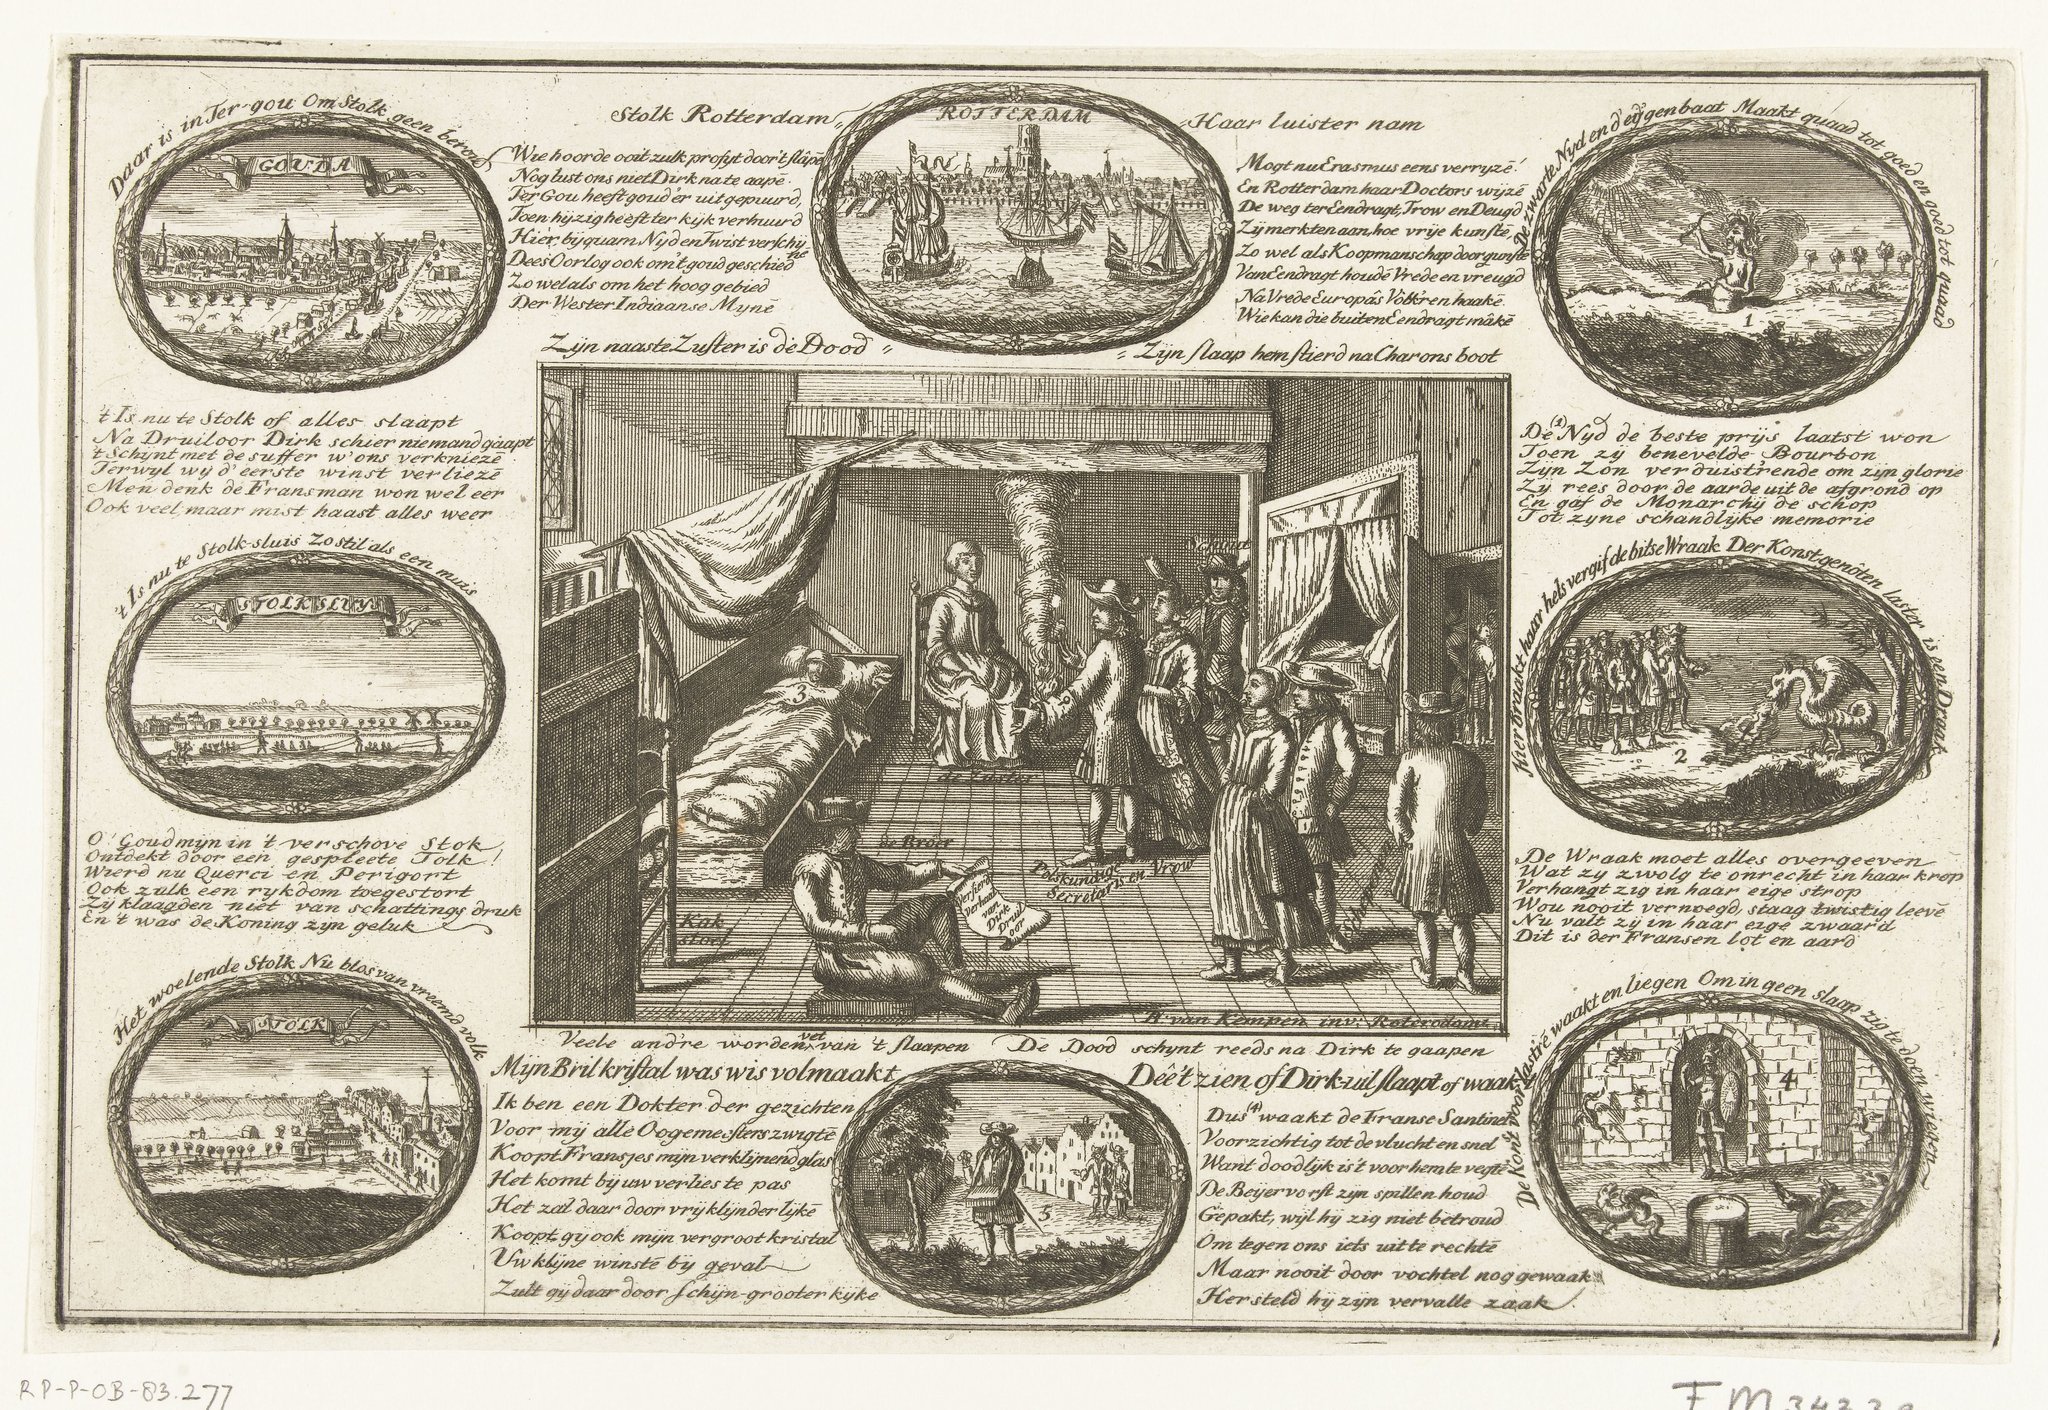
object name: cartoon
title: De slapende boer van Stolwijk, 1707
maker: carel allard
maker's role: print maker, publisher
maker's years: 1648-1709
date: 1707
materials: paper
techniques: etching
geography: northern netherlands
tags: sleeping in bed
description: De slapende boer van Stolwijk (Dirk Klaasz de Bakker) gebruikt in een spotprent op de Fransen in het jaar 1707. Centraal het bed met de slapende man waaromheen artsen en toeschouwers staan verzameld. Deze voorstelling omringd door acht kleinere scènes met stadsgezichten en emblemen. Met opschriften in de plaat in het Nederlands.